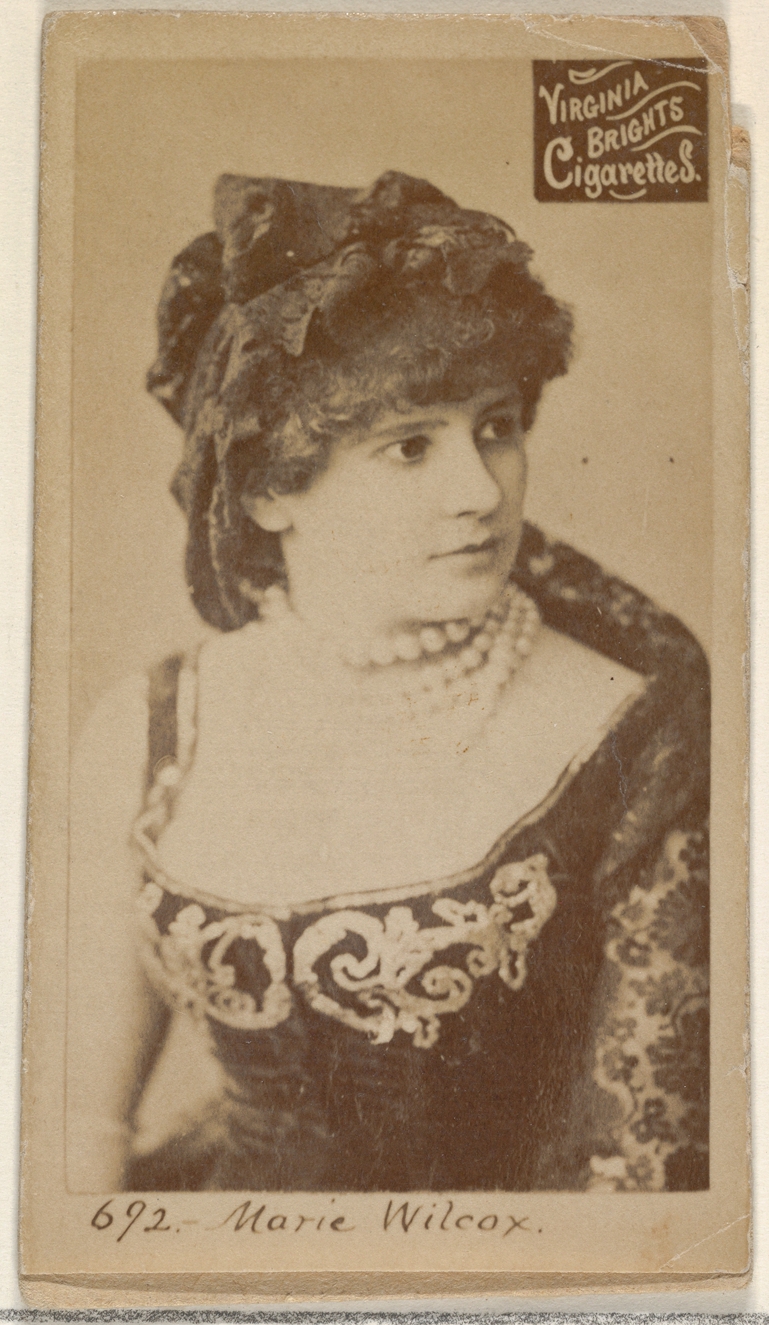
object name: photograph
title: Card 692, Marie Wilcox, from the Actors and Actresses series (N45, Type 2) for Virginia Brights Cigarettes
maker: allen & ginter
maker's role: publisher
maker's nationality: american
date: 1888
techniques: albumen silver print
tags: portraits,women,actresses